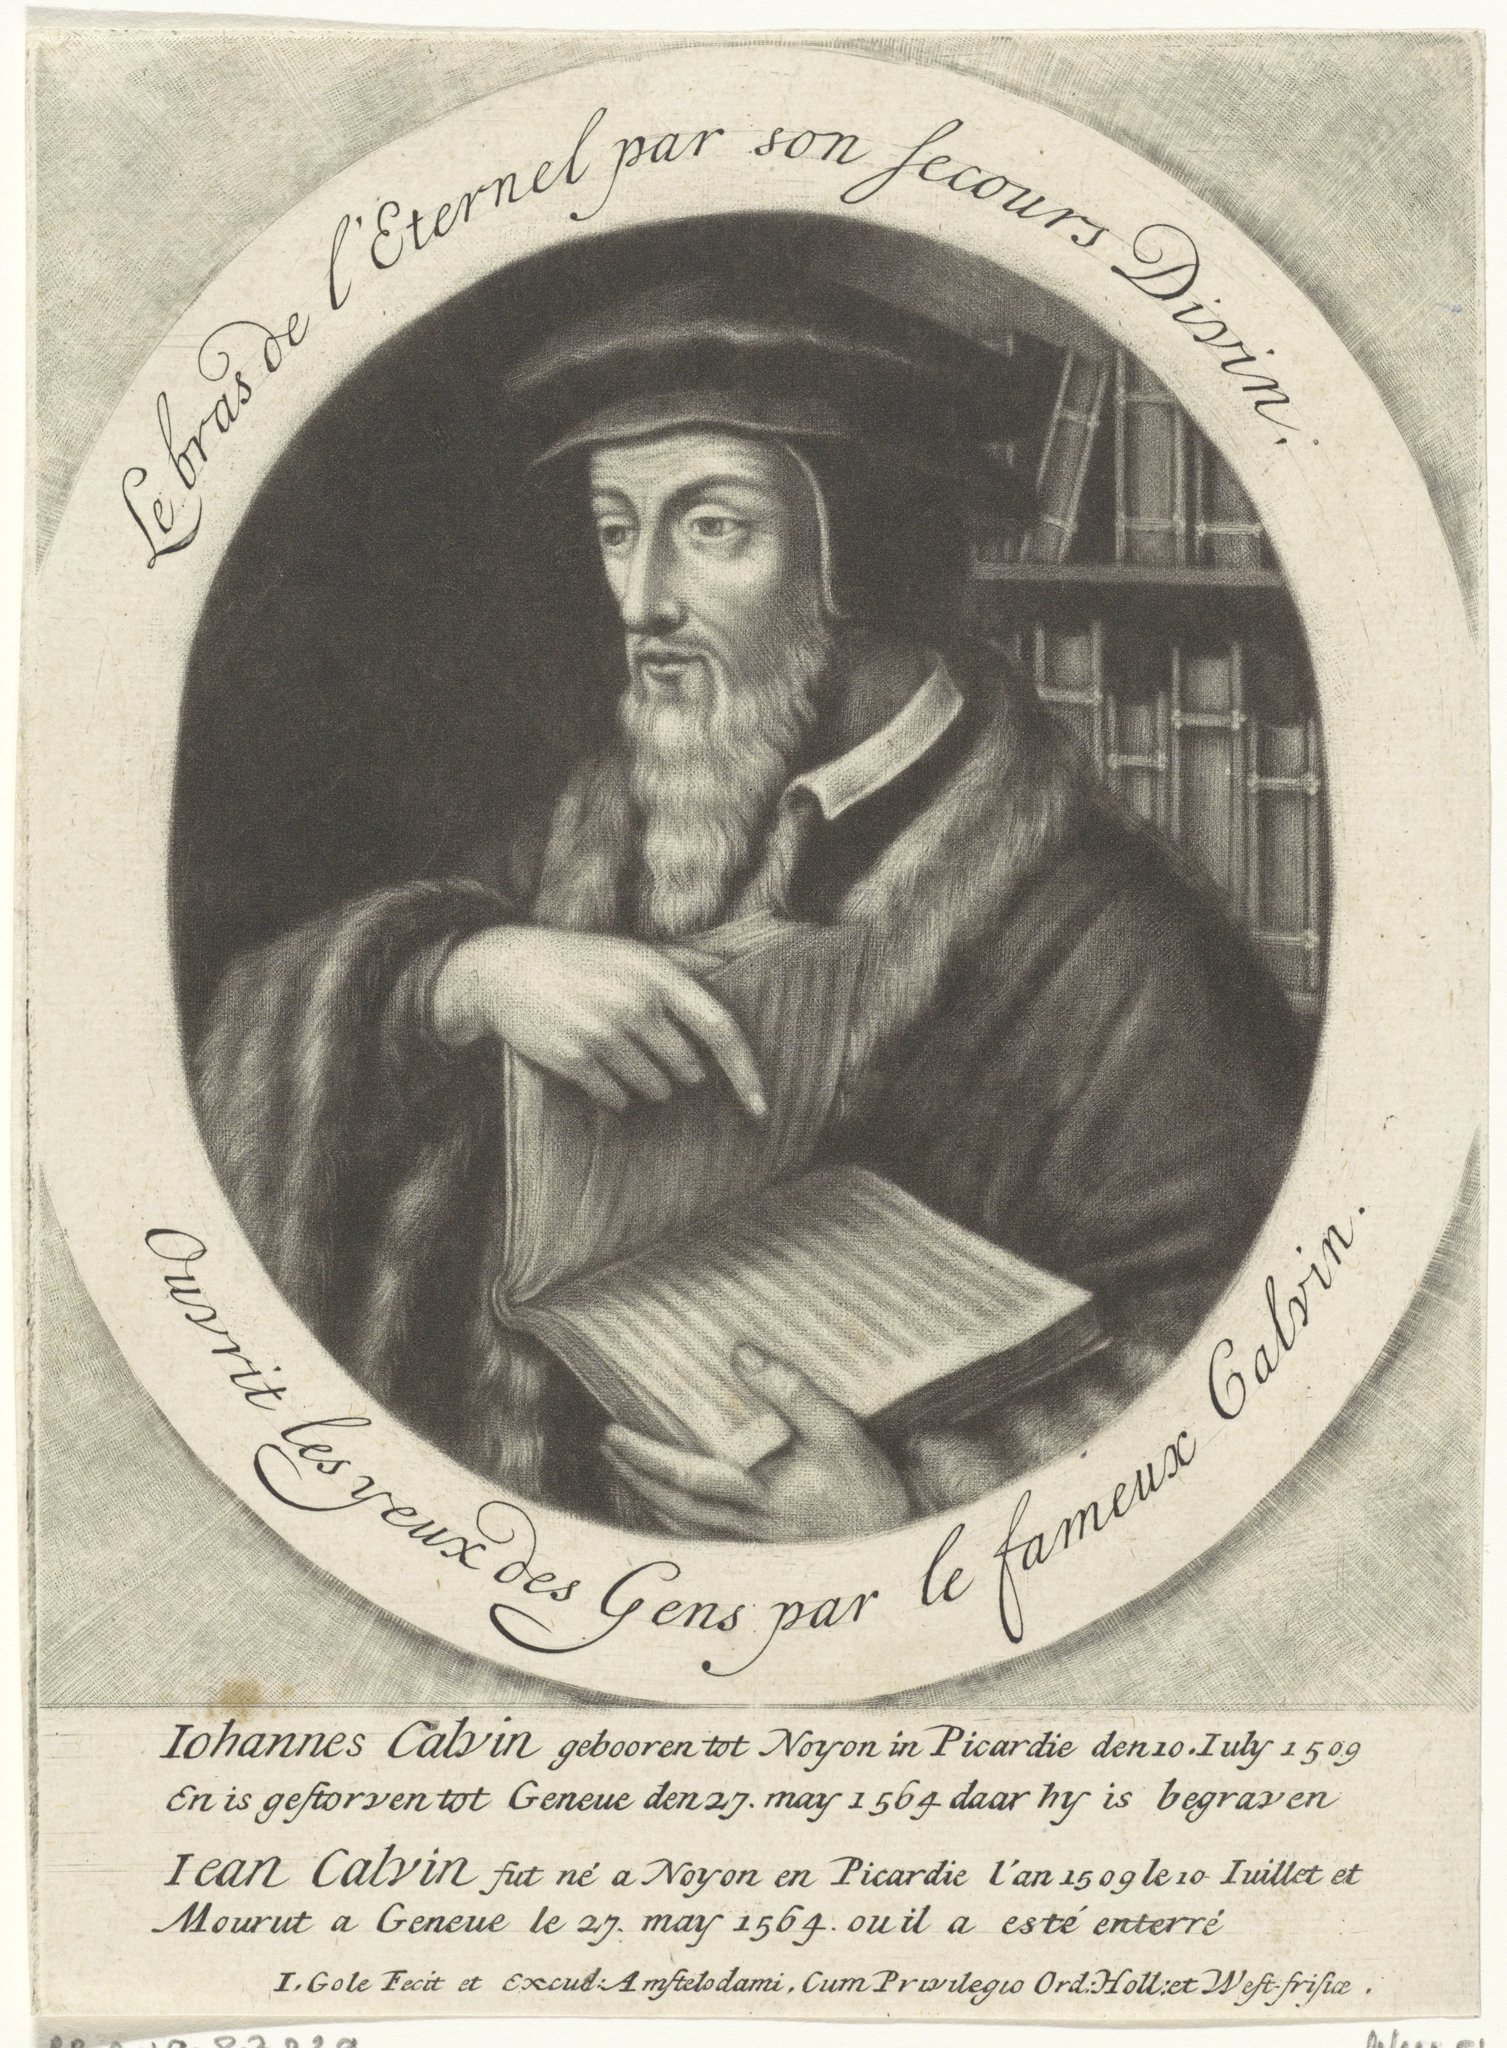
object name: print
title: Portret van de reformator Johannes Calvijn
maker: jacob gole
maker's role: print maker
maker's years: 1660-1724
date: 1670-1724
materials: paper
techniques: engraving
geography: amsterdam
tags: book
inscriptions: collector's mark: Lugt 2228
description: De kerkhervormer Johannes Calvijn, met hoofddeksel. Zijn linkerhand rust op een opengeslagen boek. In de marge zijn geboorte- en sterfdatum.